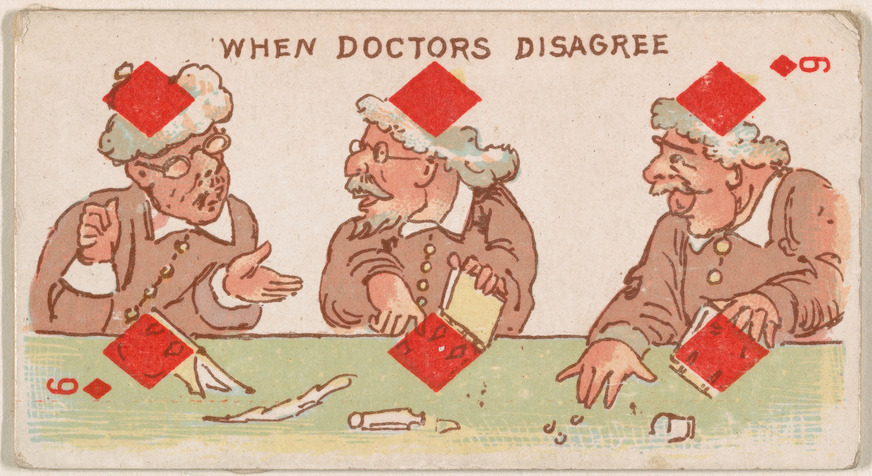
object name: print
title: Six of Diamonds, When Doctors Disagree, from Harlequin Cards, 2nd Series (N220) issued by Kinney Bros.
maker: kinney brothers tobacco company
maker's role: publisher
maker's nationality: american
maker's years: 1869-2011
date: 1889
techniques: color lithograph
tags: men,playing cards